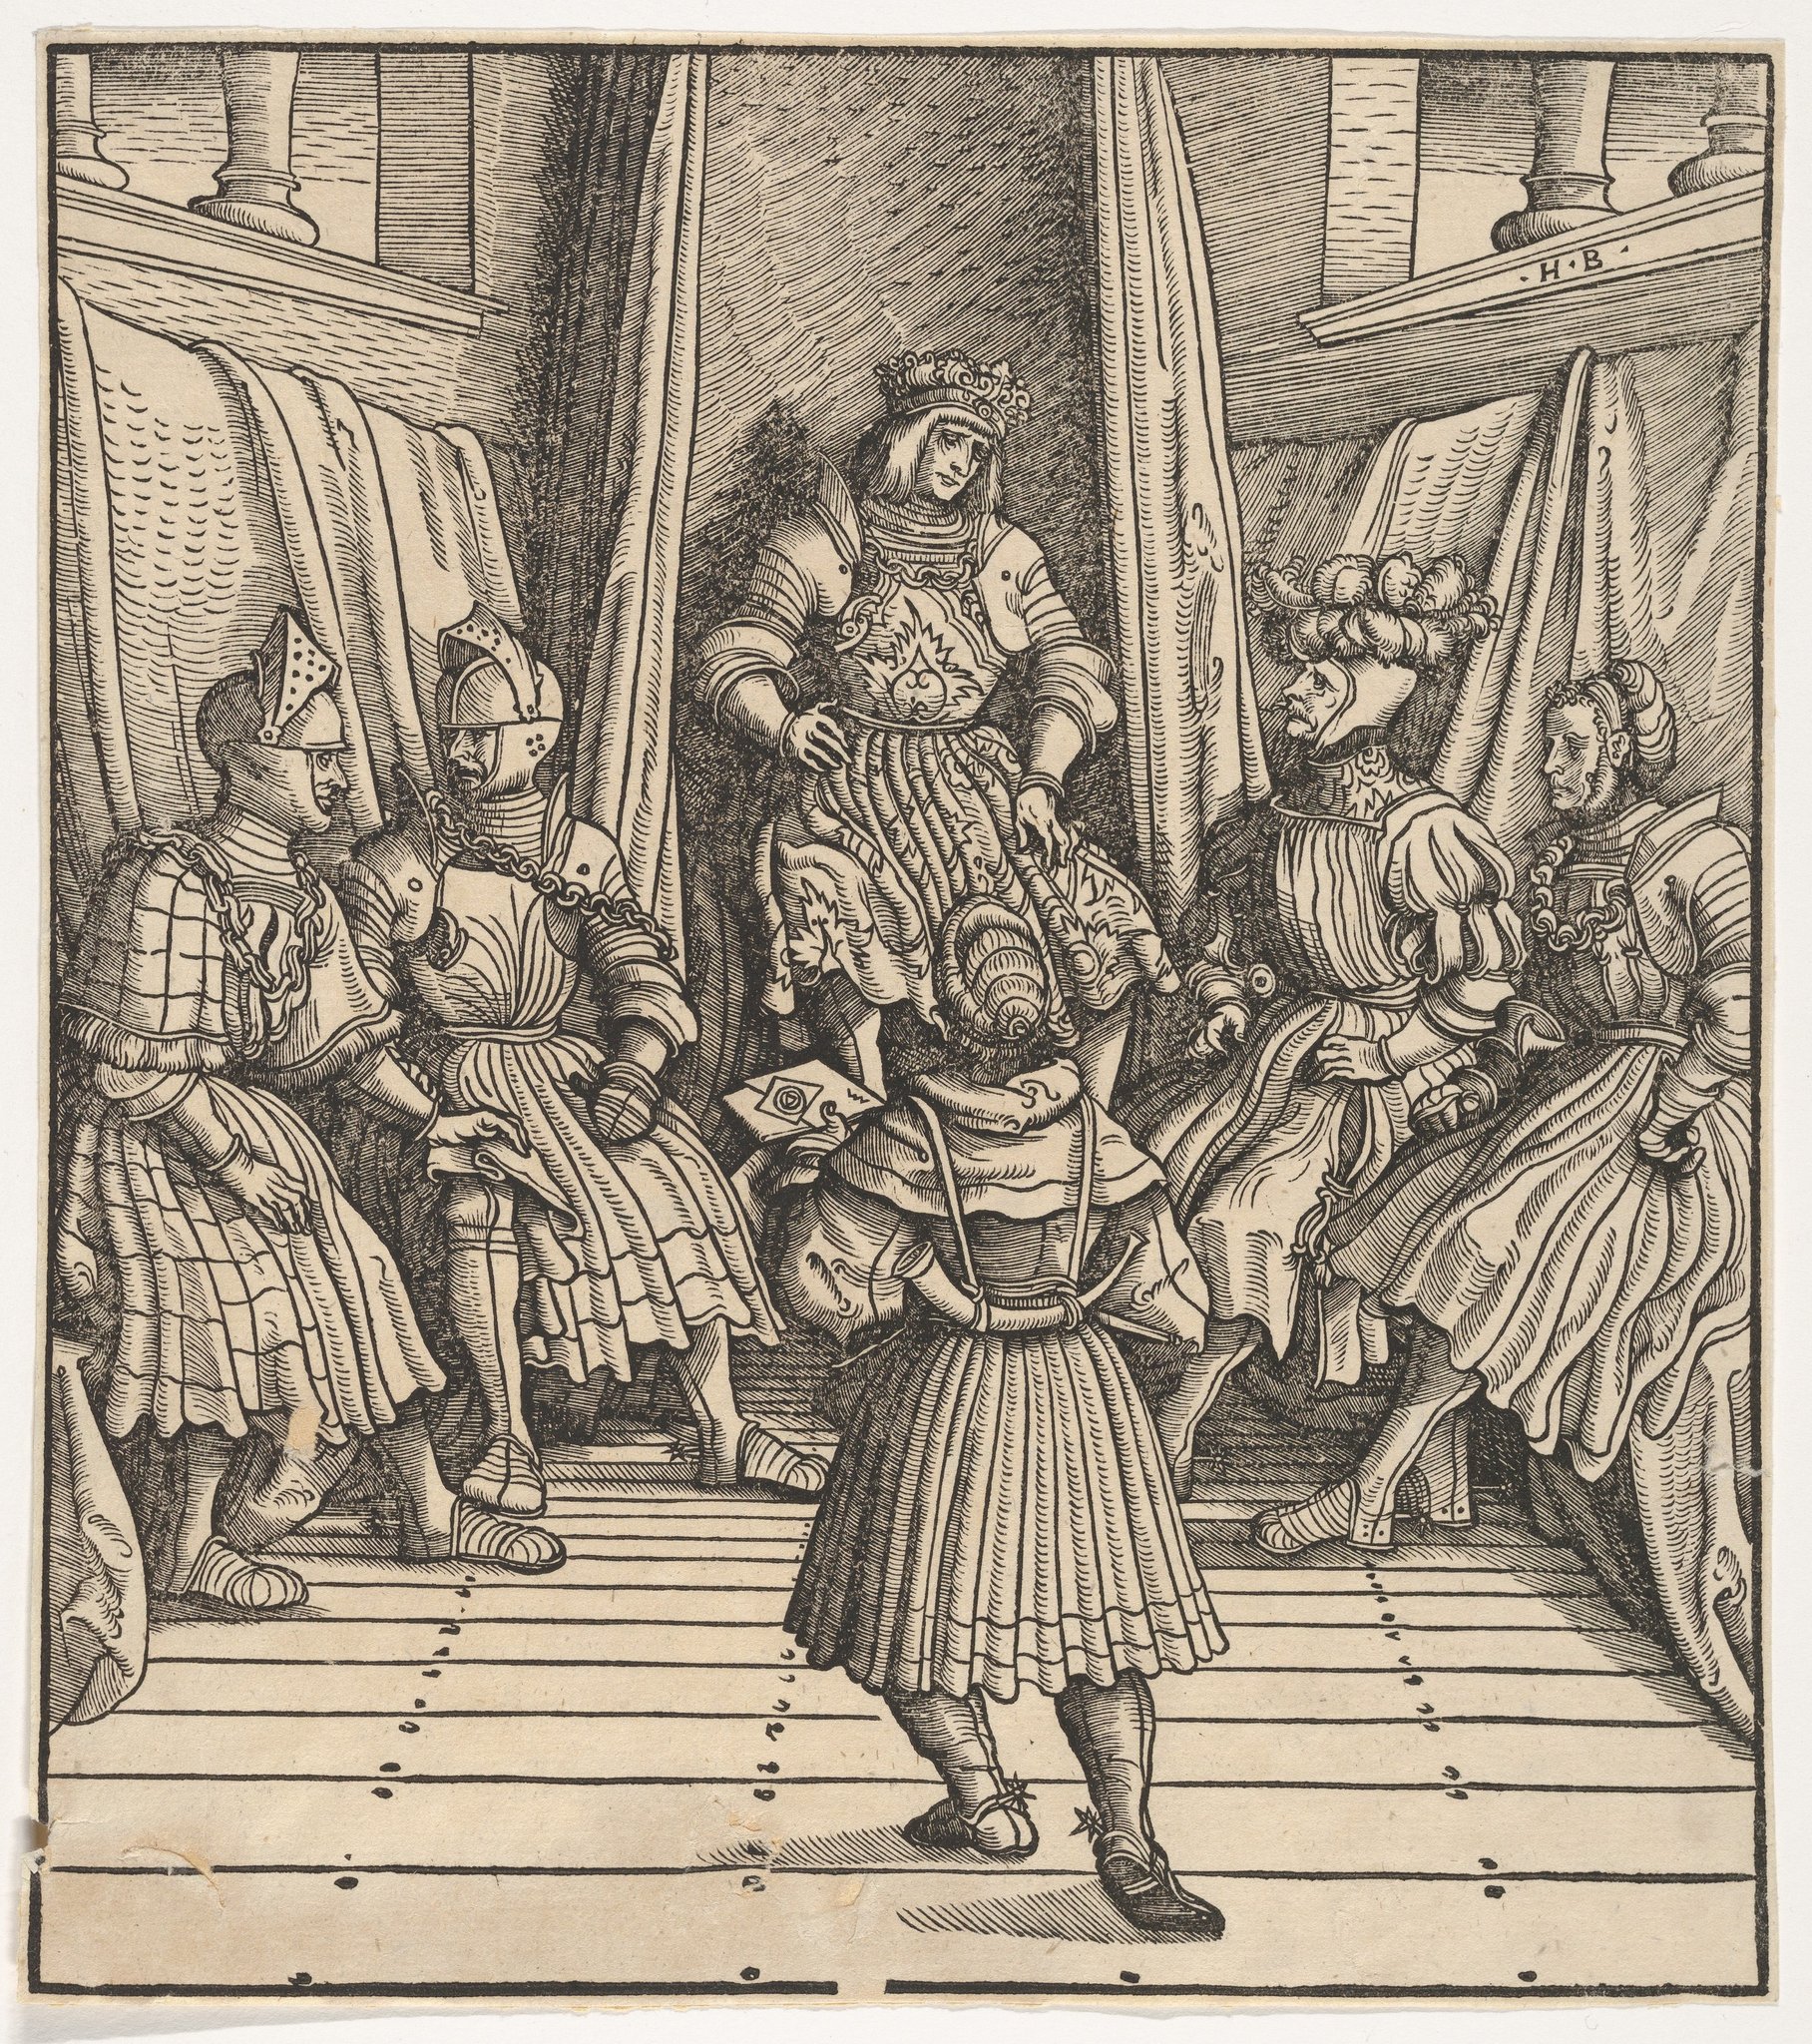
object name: print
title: The White King in a Council with the Welsh Party, Receiving a Message, from "Der Weisskunig"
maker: hans burgkmair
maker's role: artist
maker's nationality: german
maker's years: 1473-1531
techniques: woodcut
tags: kings,men